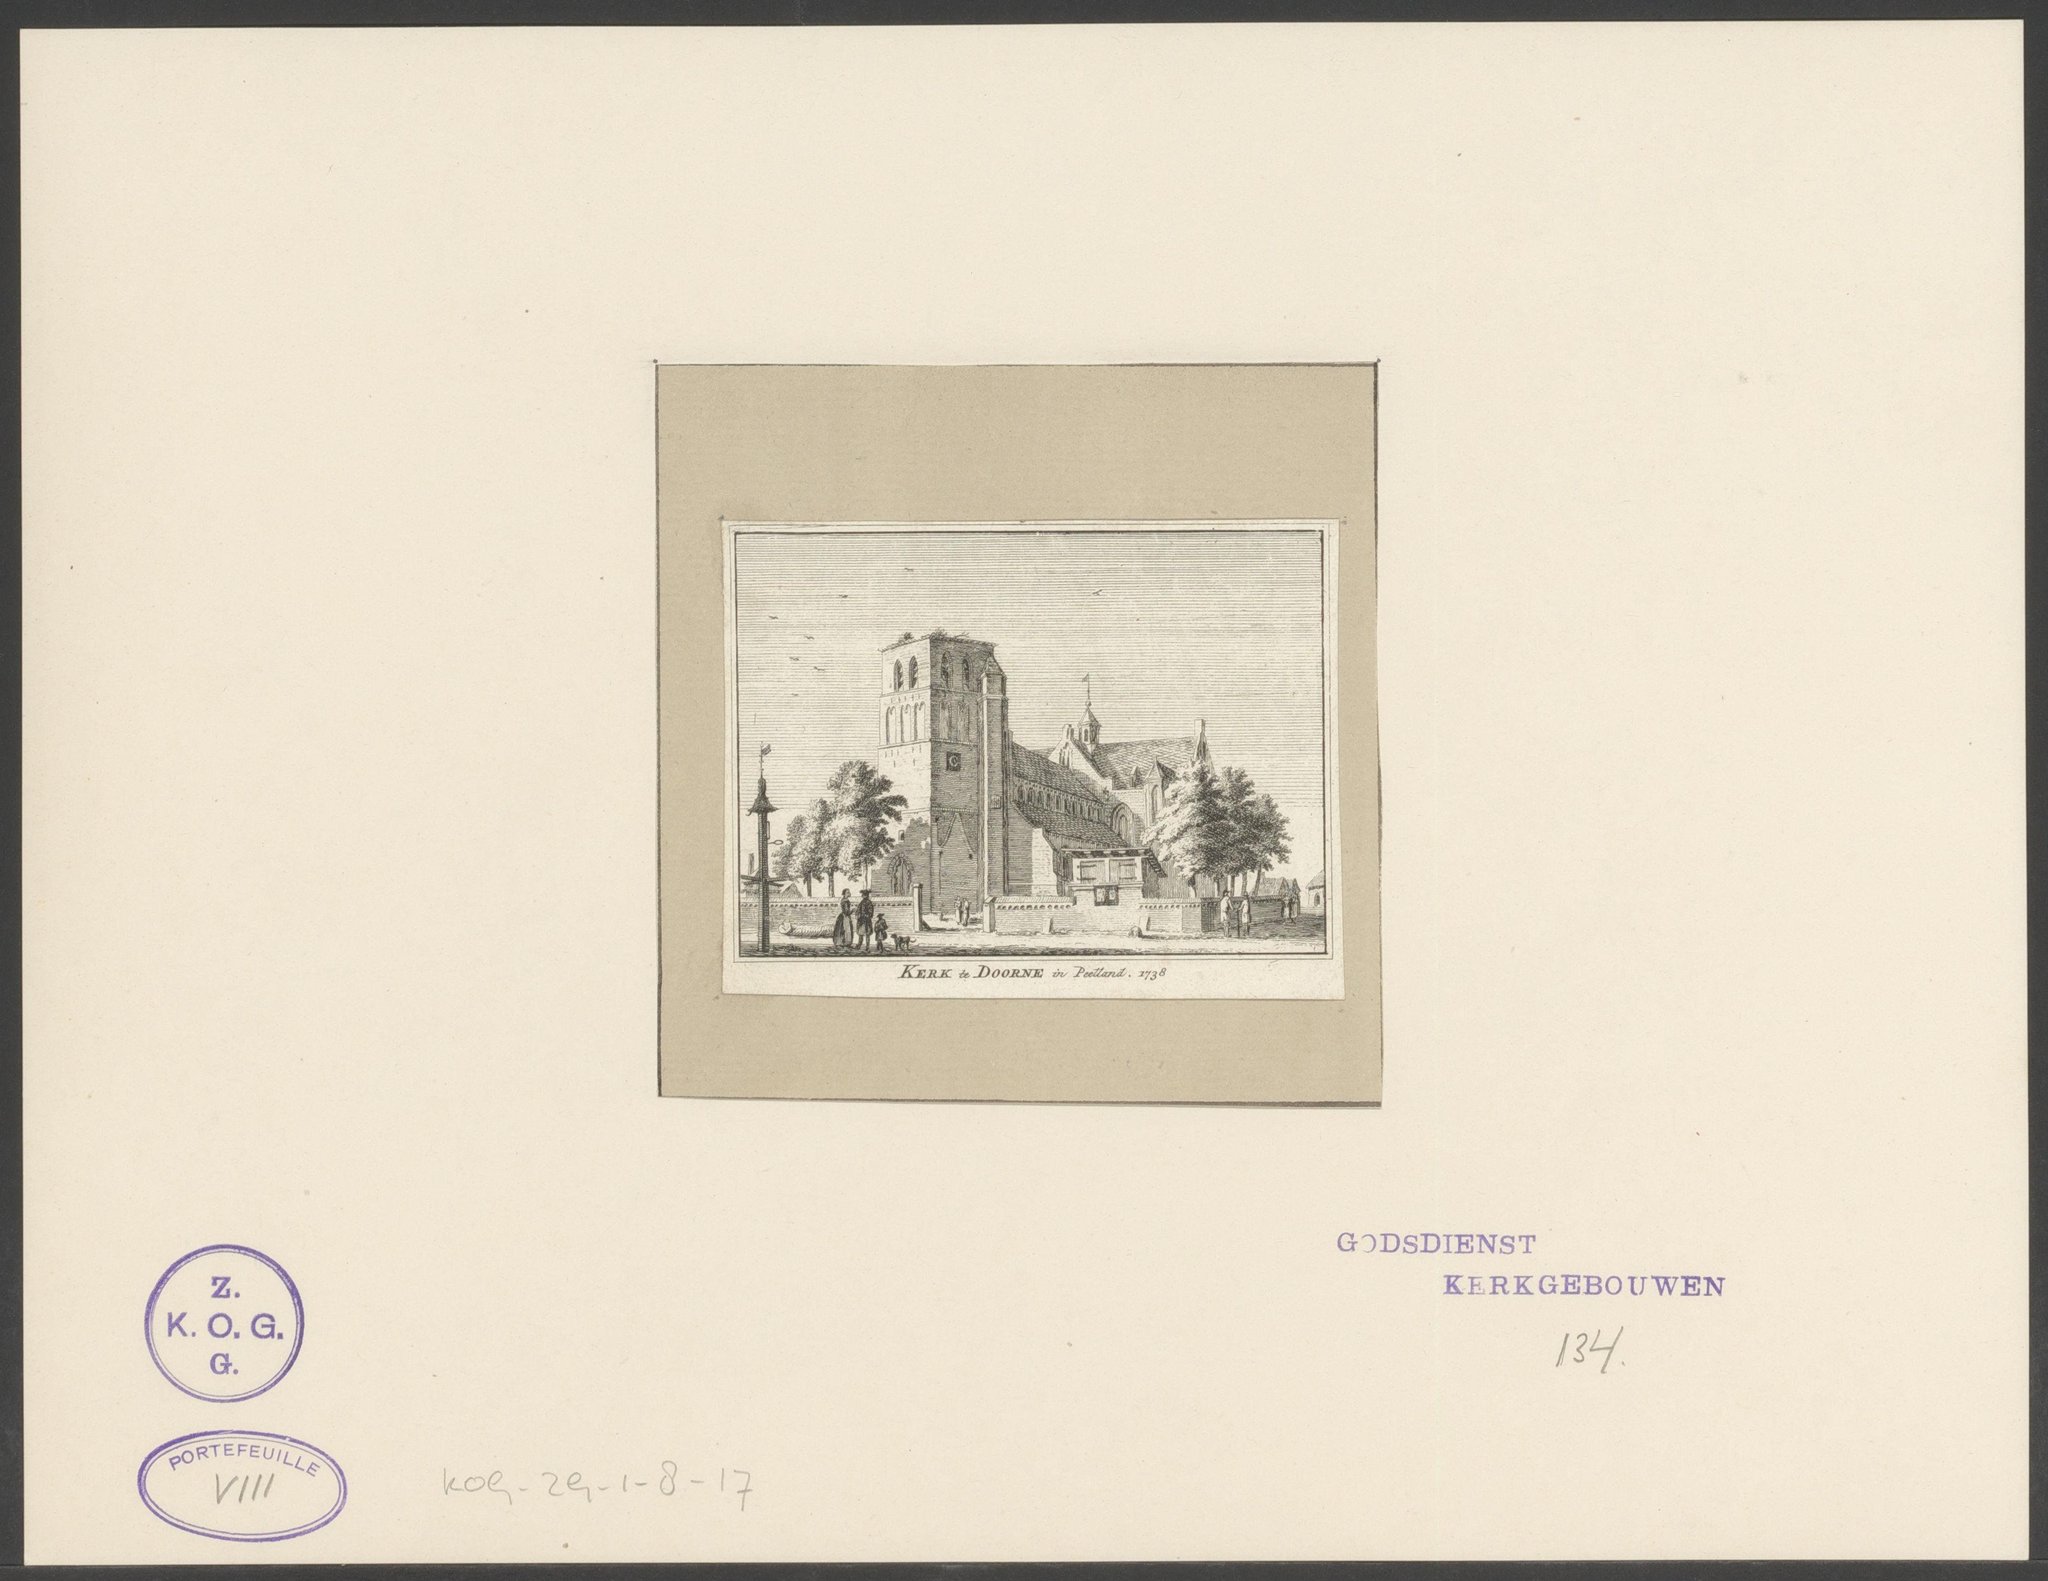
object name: print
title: De Sint-Willibrorduskerk te Deurne, 1738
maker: hendrik spilman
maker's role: draughtsman, painter, print maker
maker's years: 1721-1784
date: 1746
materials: paper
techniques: engraving, etching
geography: netherlands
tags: church (exterior), public road in village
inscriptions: collector's mark, collector's mark: Lugt 1641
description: Gezicht op de Sint-Willibrorduskerk te Deurne, omstreeks 1738. Afgesneden bovenste deel van een plaat met twee voorstellingen. Onderwerpsrubrieken binnen de Atlas Zeden en Gewoonten: Kerk en kerkwezen & Armwezen en liefdadige instellingen; Kerkgebouwen elders. A-E.